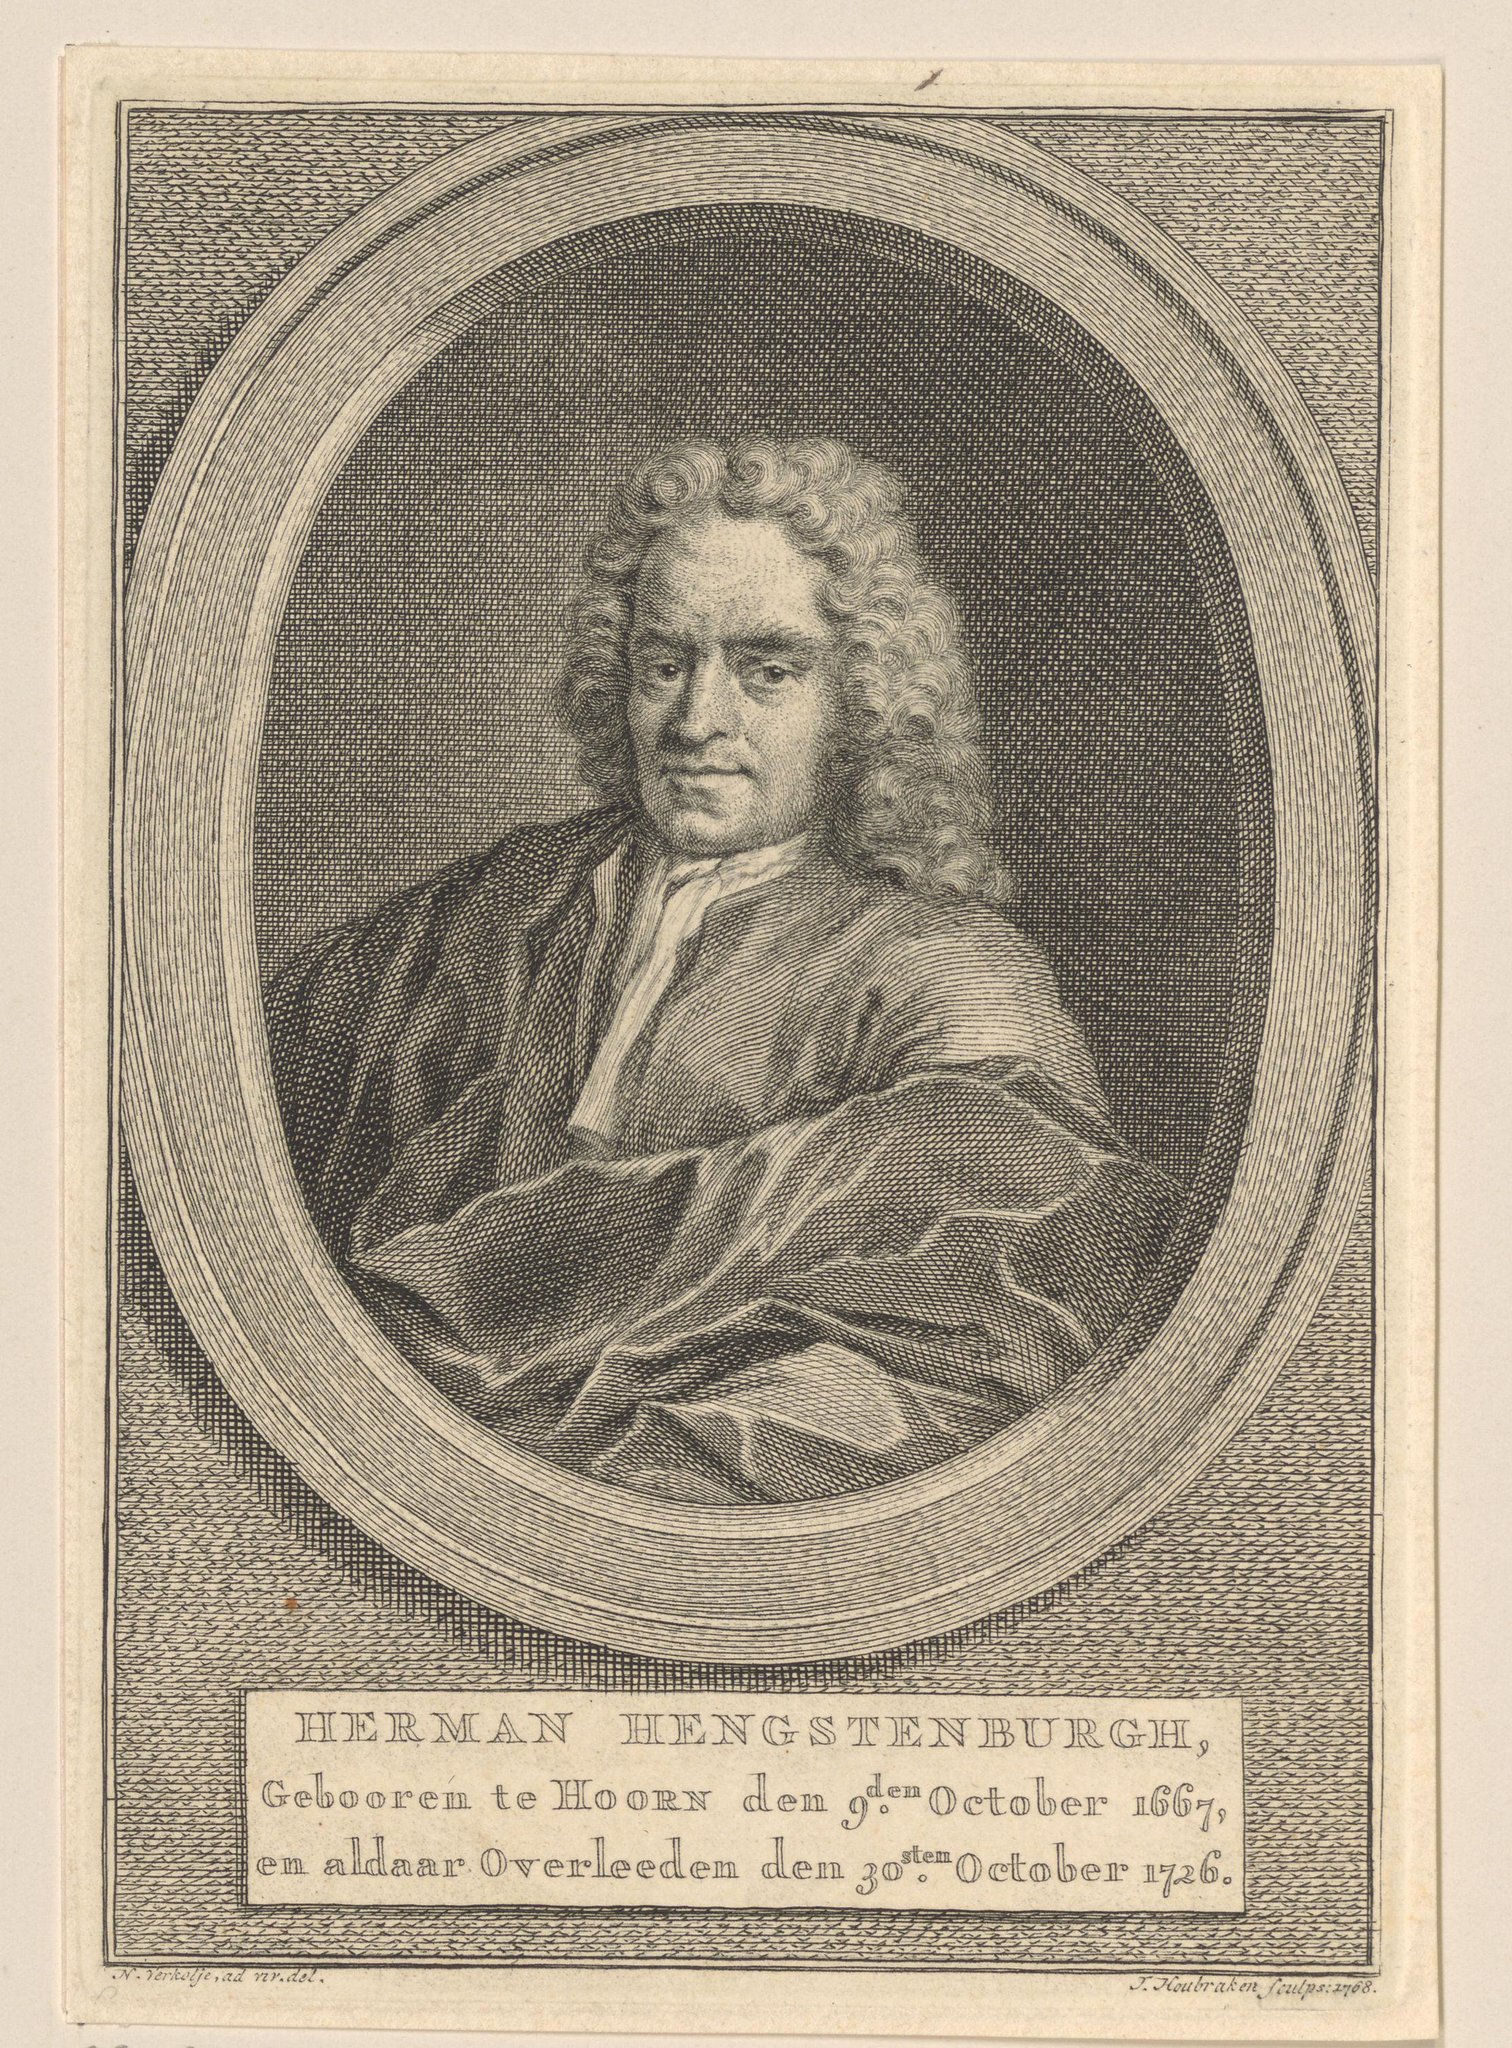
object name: print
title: Portret van Herman Hengstenburgh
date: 1768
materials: paper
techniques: engraving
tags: historical persons, portrait, self-portrait of painter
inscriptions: collector's mark: Lugt 2228